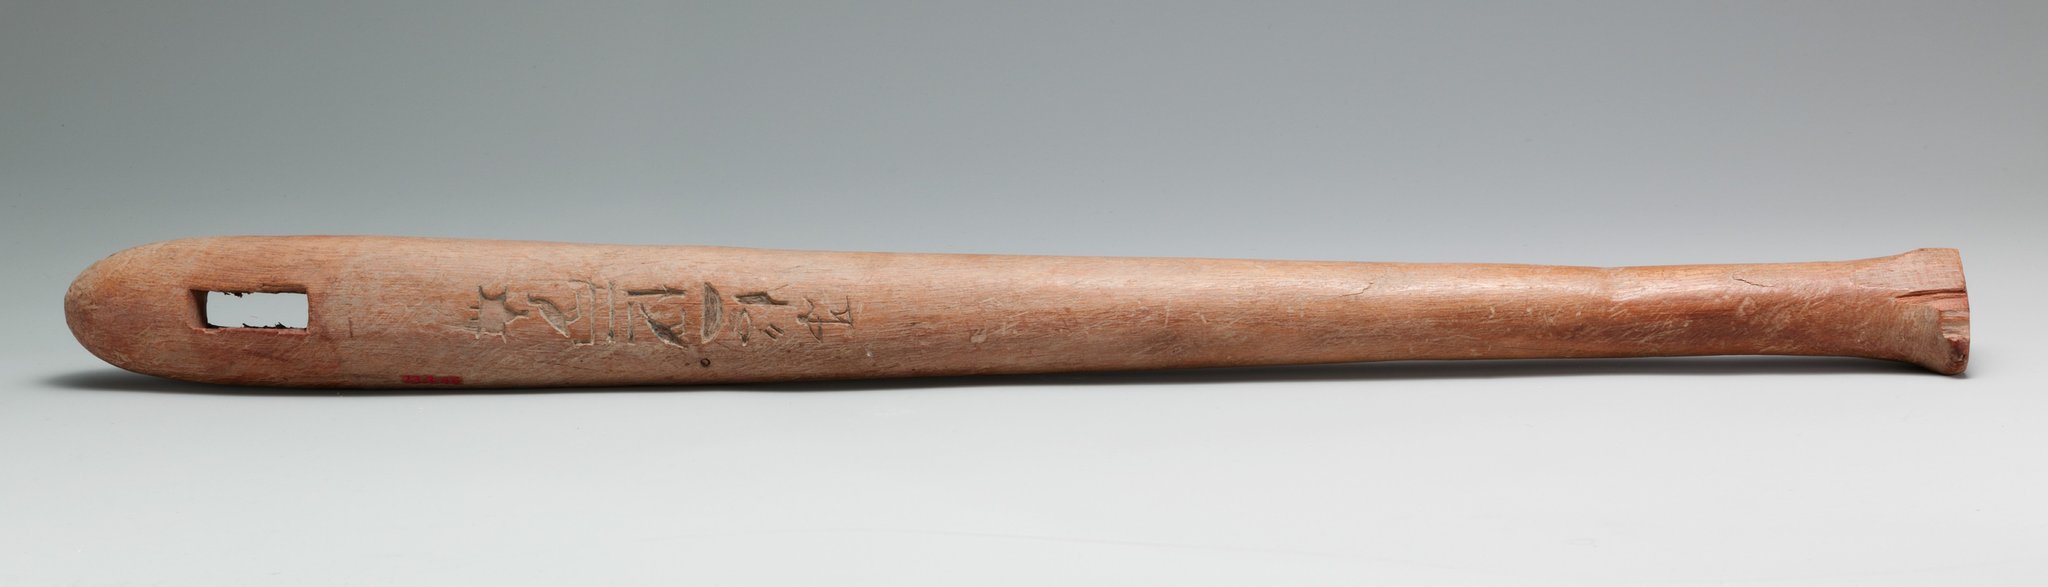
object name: whip handle, nebiry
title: Whip handle of Nebiry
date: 1479-1458 BCE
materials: paint, wood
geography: egypt